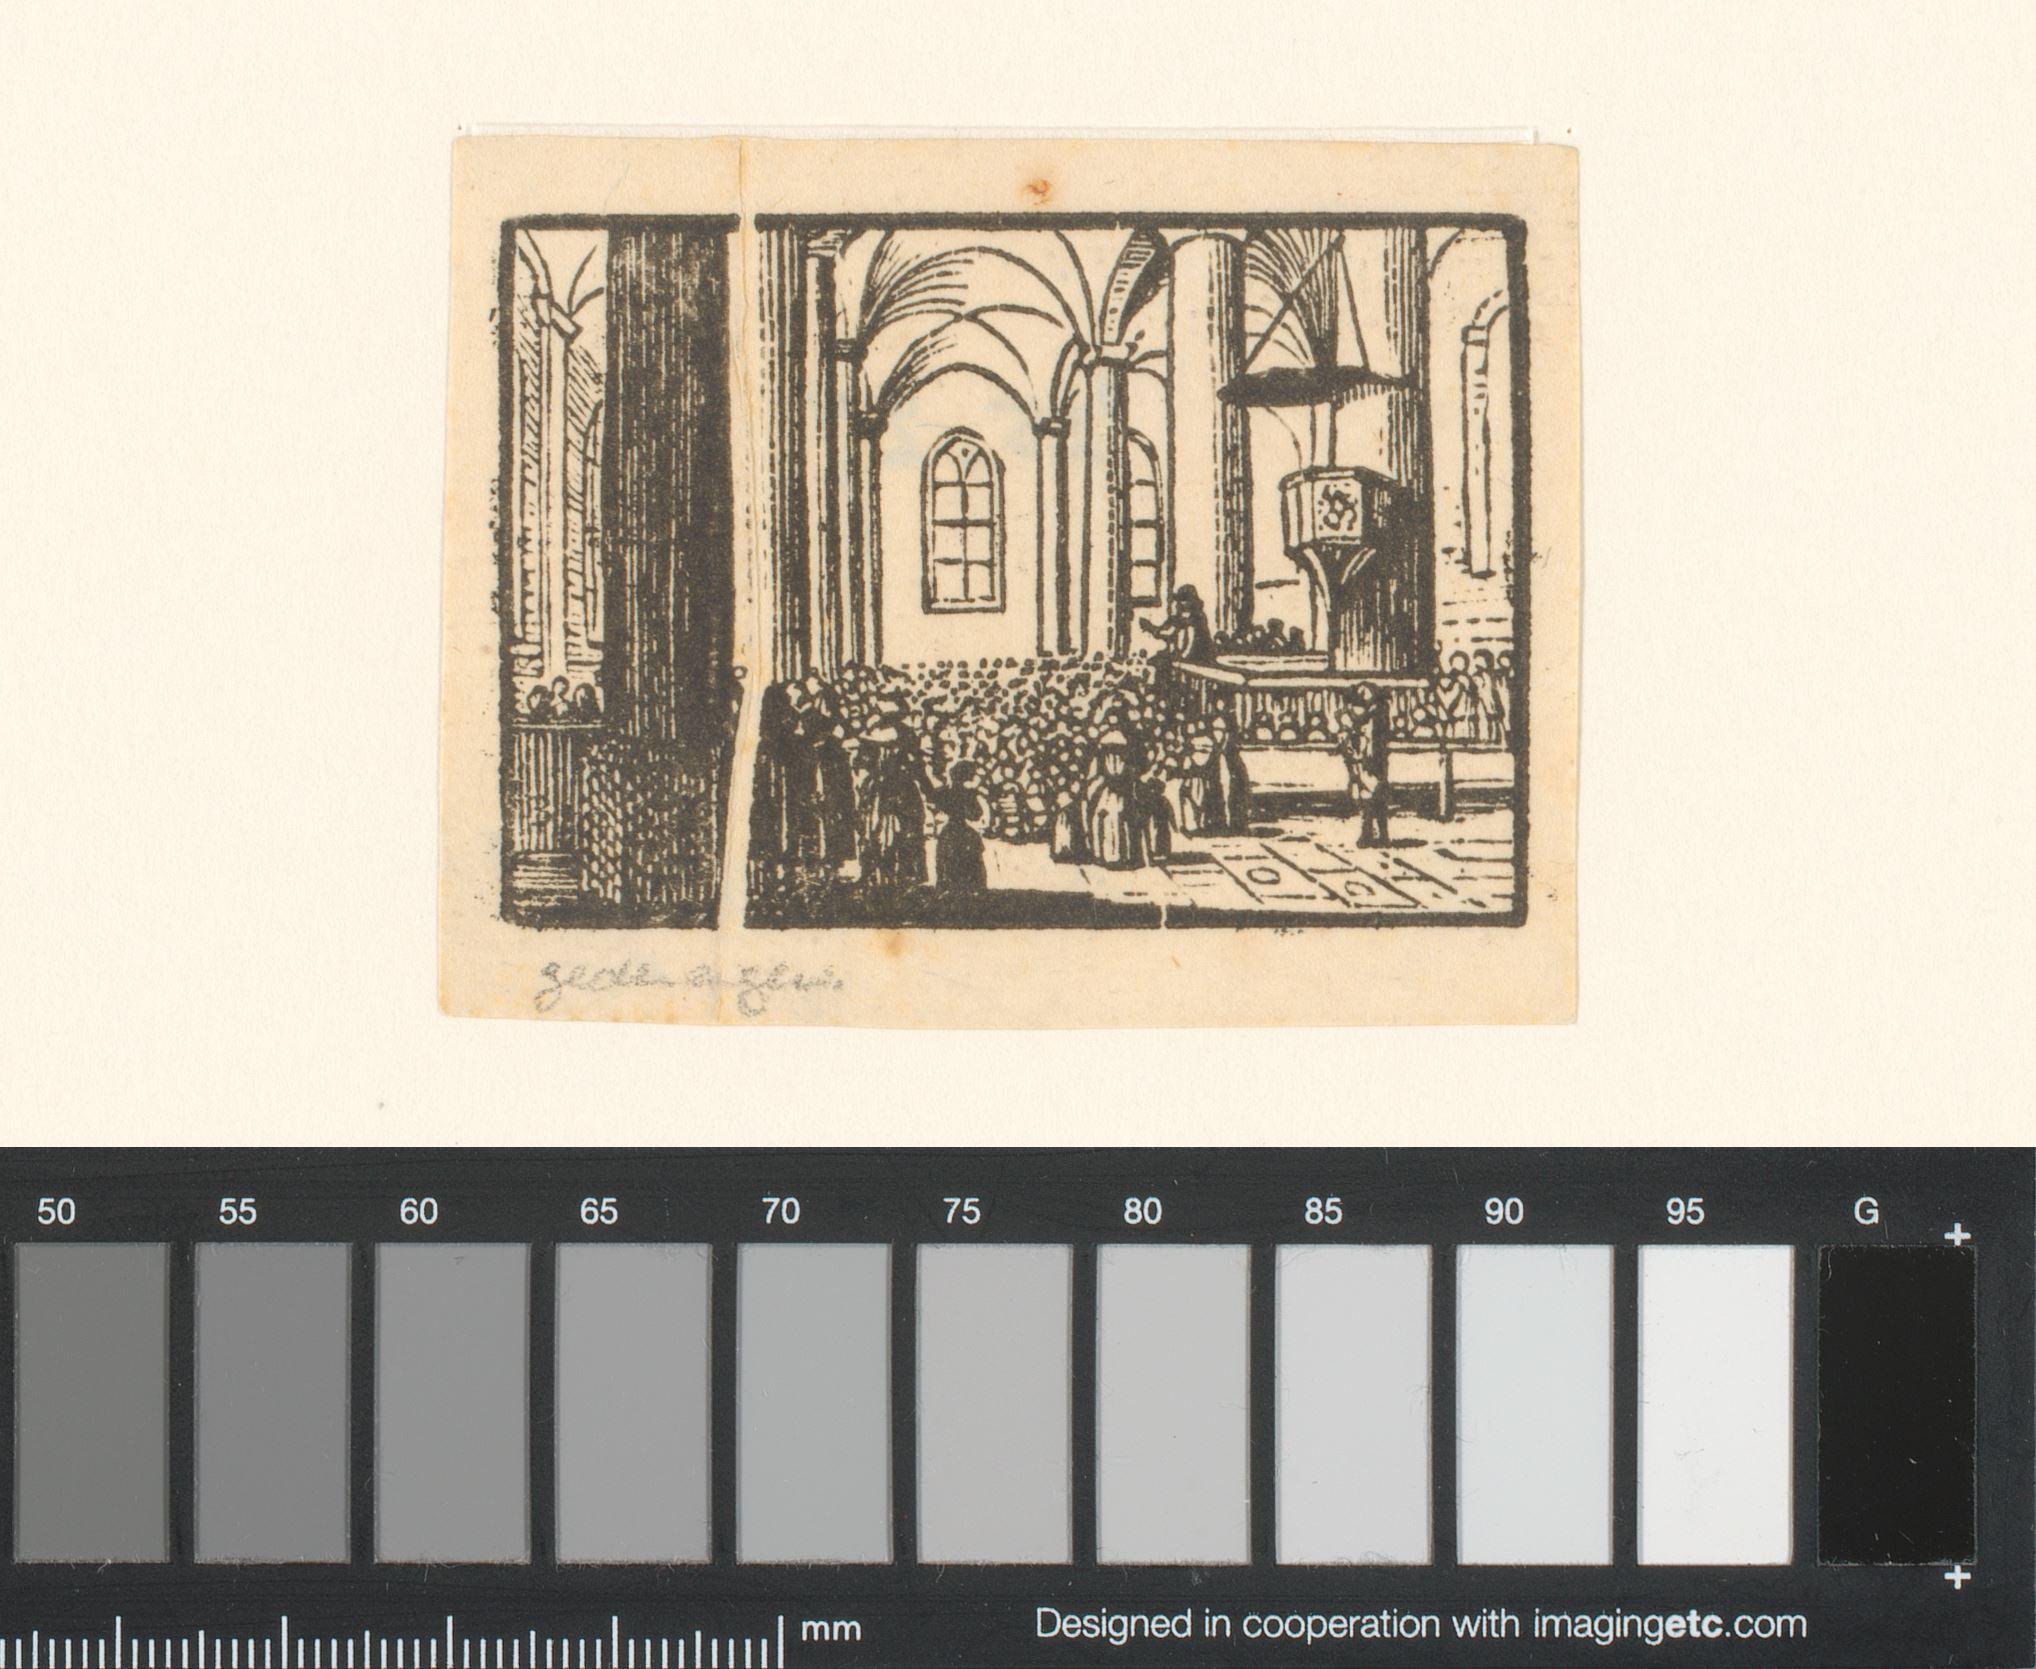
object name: print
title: Protestantse kerk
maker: dirck de bray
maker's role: draughtsman, painter, print maker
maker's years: 1625-1694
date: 1645-1694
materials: paper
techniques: woodcut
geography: northern netherlands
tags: protestant churches and denominations, interior of church, sermon ~ holy mass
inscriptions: collector's mark: Lugt 698, collector's mark: Lugt 2228